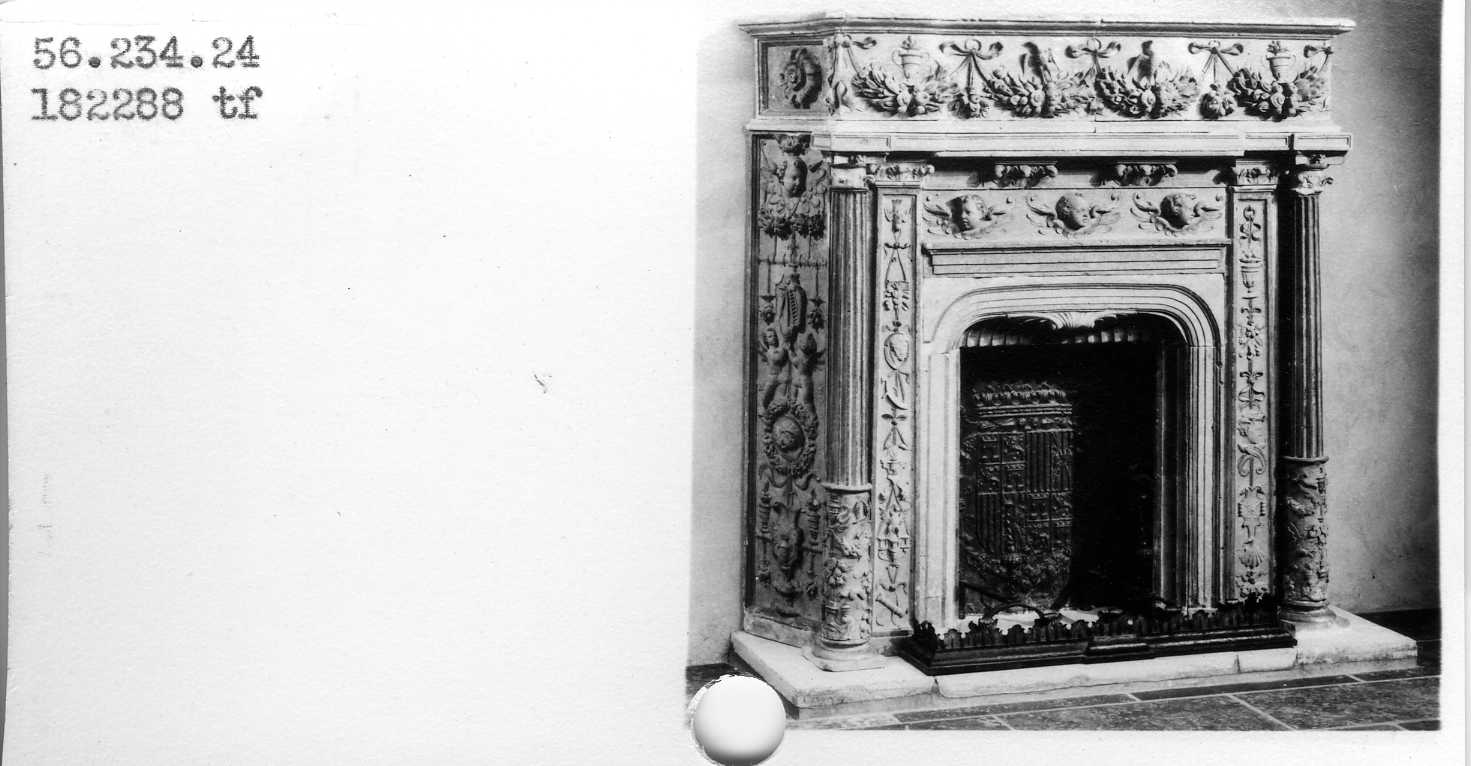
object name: fireback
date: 1501-1600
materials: iron